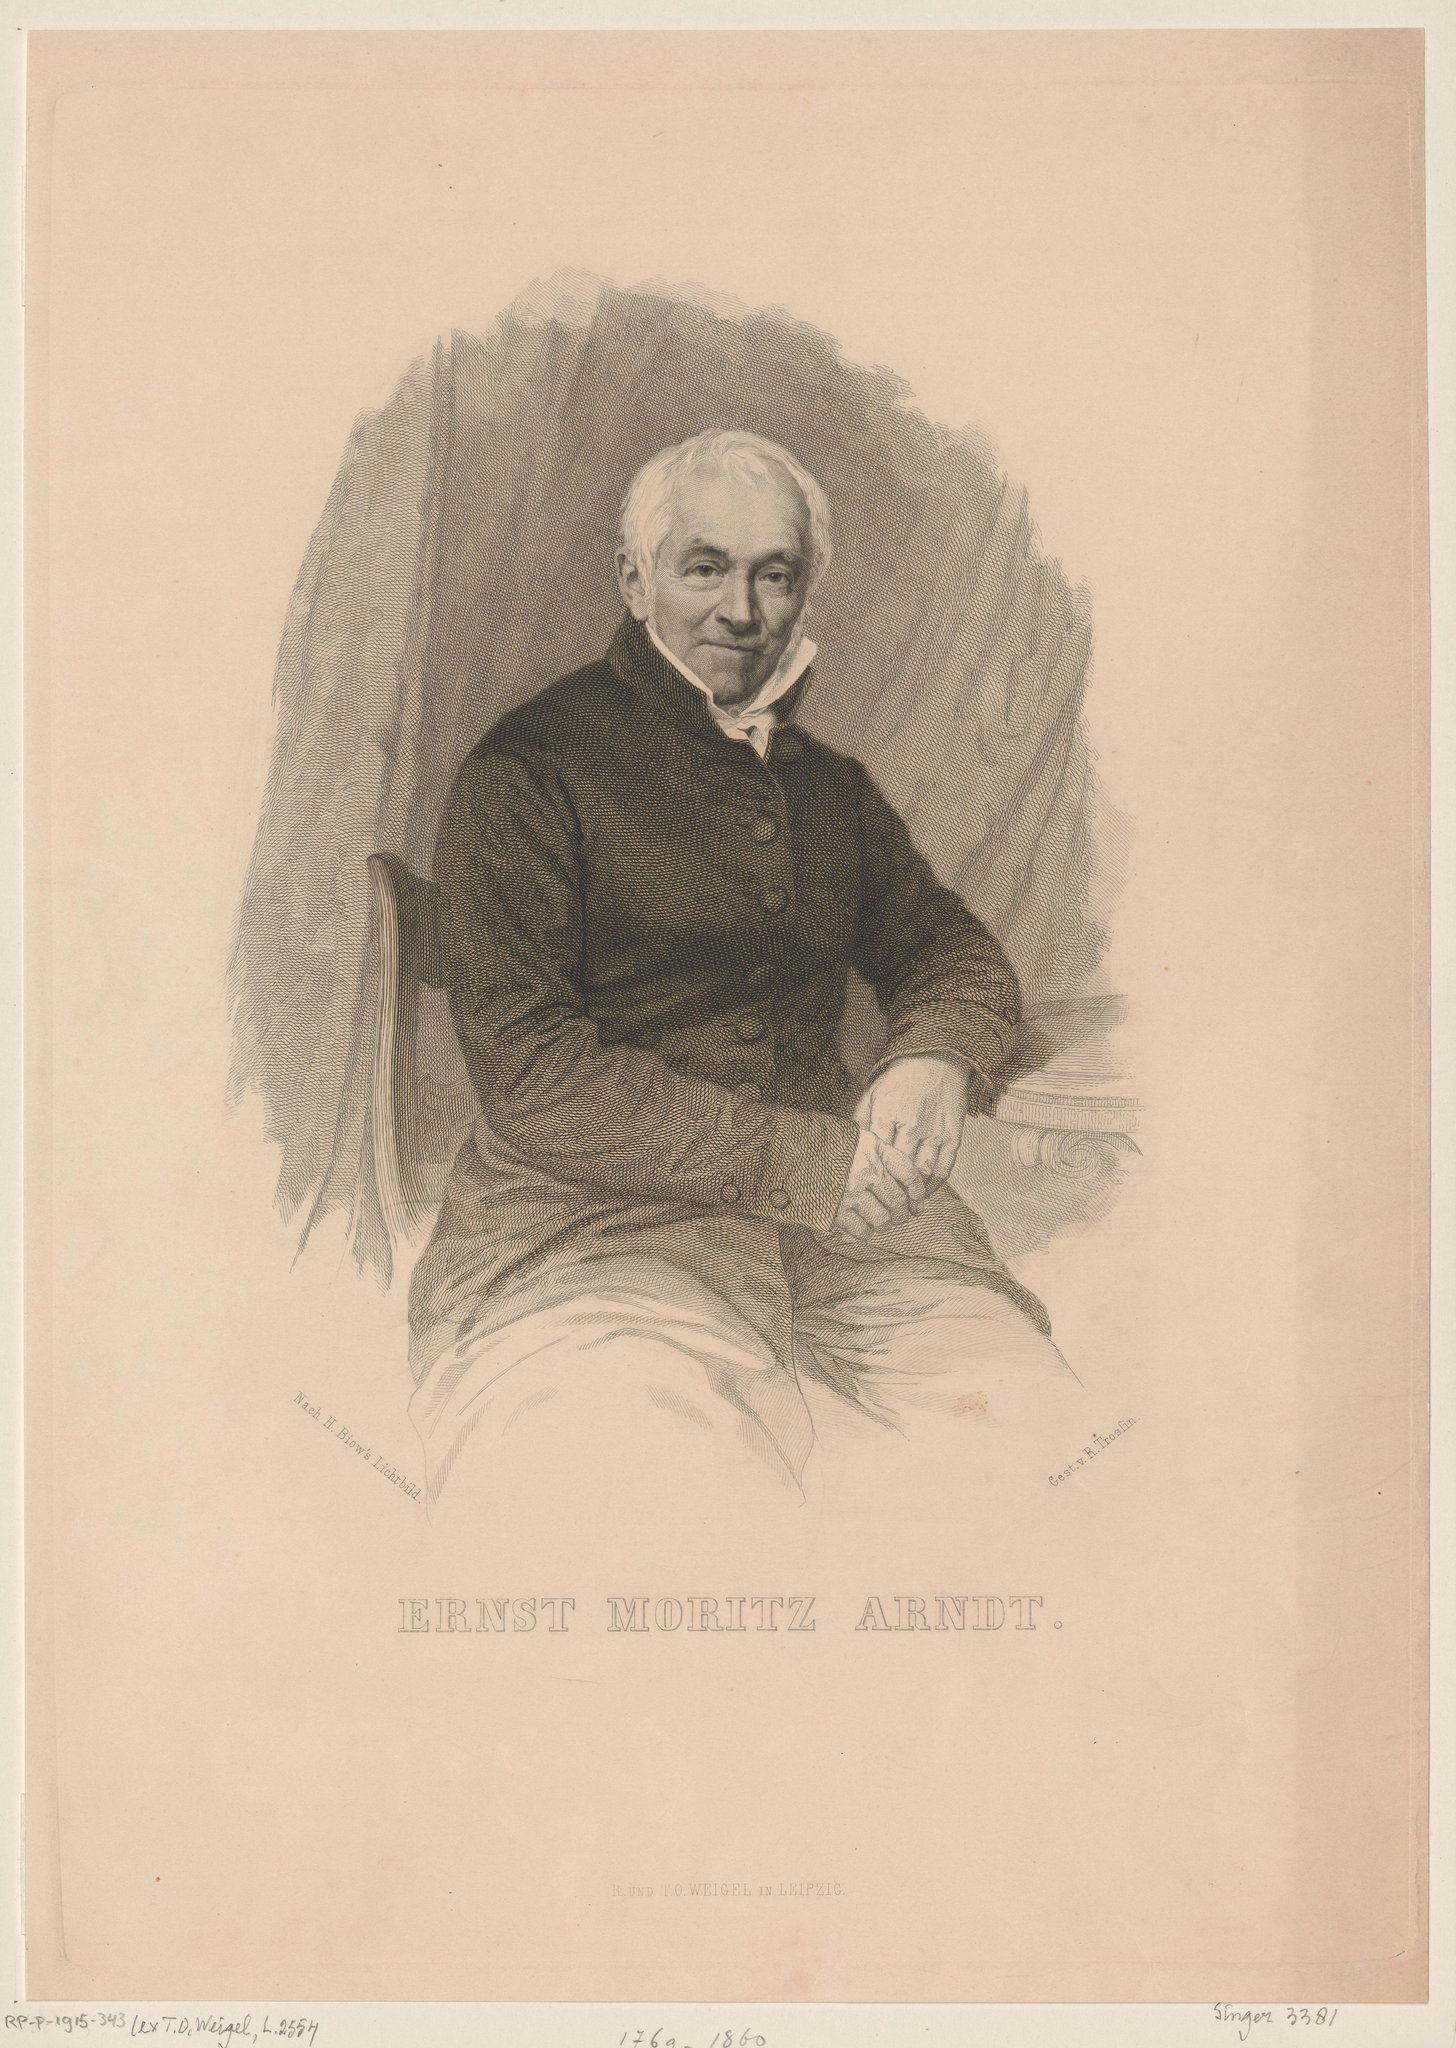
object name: print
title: Portret van Ernst Moritz Arndt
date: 1830-1867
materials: paper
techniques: engraving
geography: leipzig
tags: historical persons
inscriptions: workshop stamp: Lugt 2554